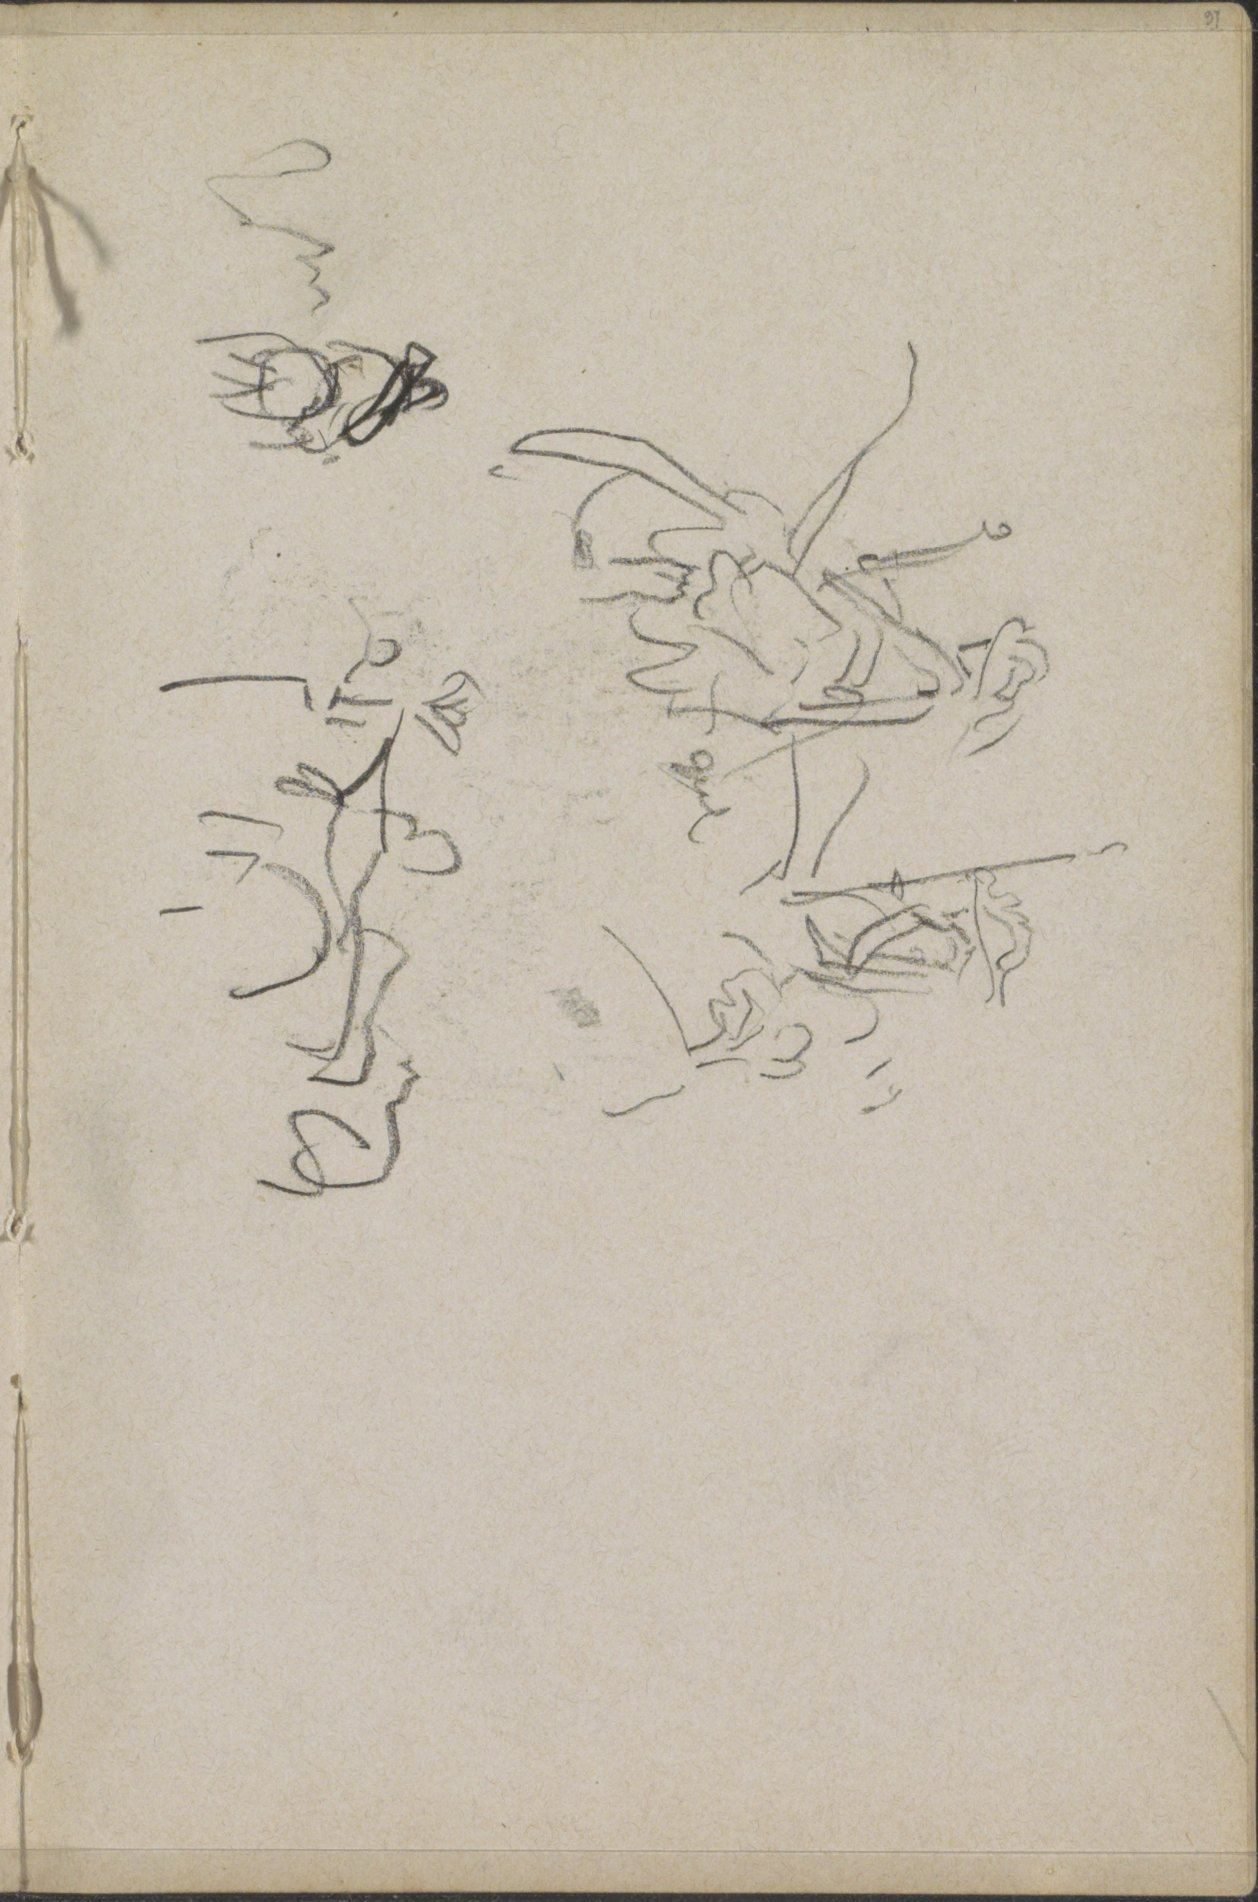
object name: sketchbook leaf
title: Ruiters in mantels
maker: marius bauer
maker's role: draughtsman, print maker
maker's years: 1867-1932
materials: chalk, paper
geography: russia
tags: riding a horse, ass, or mule; rider, horseman, horse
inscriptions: kleurnotitie, handgeschreven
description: Pagina 96 uit een schetsboek met 54 bladen.